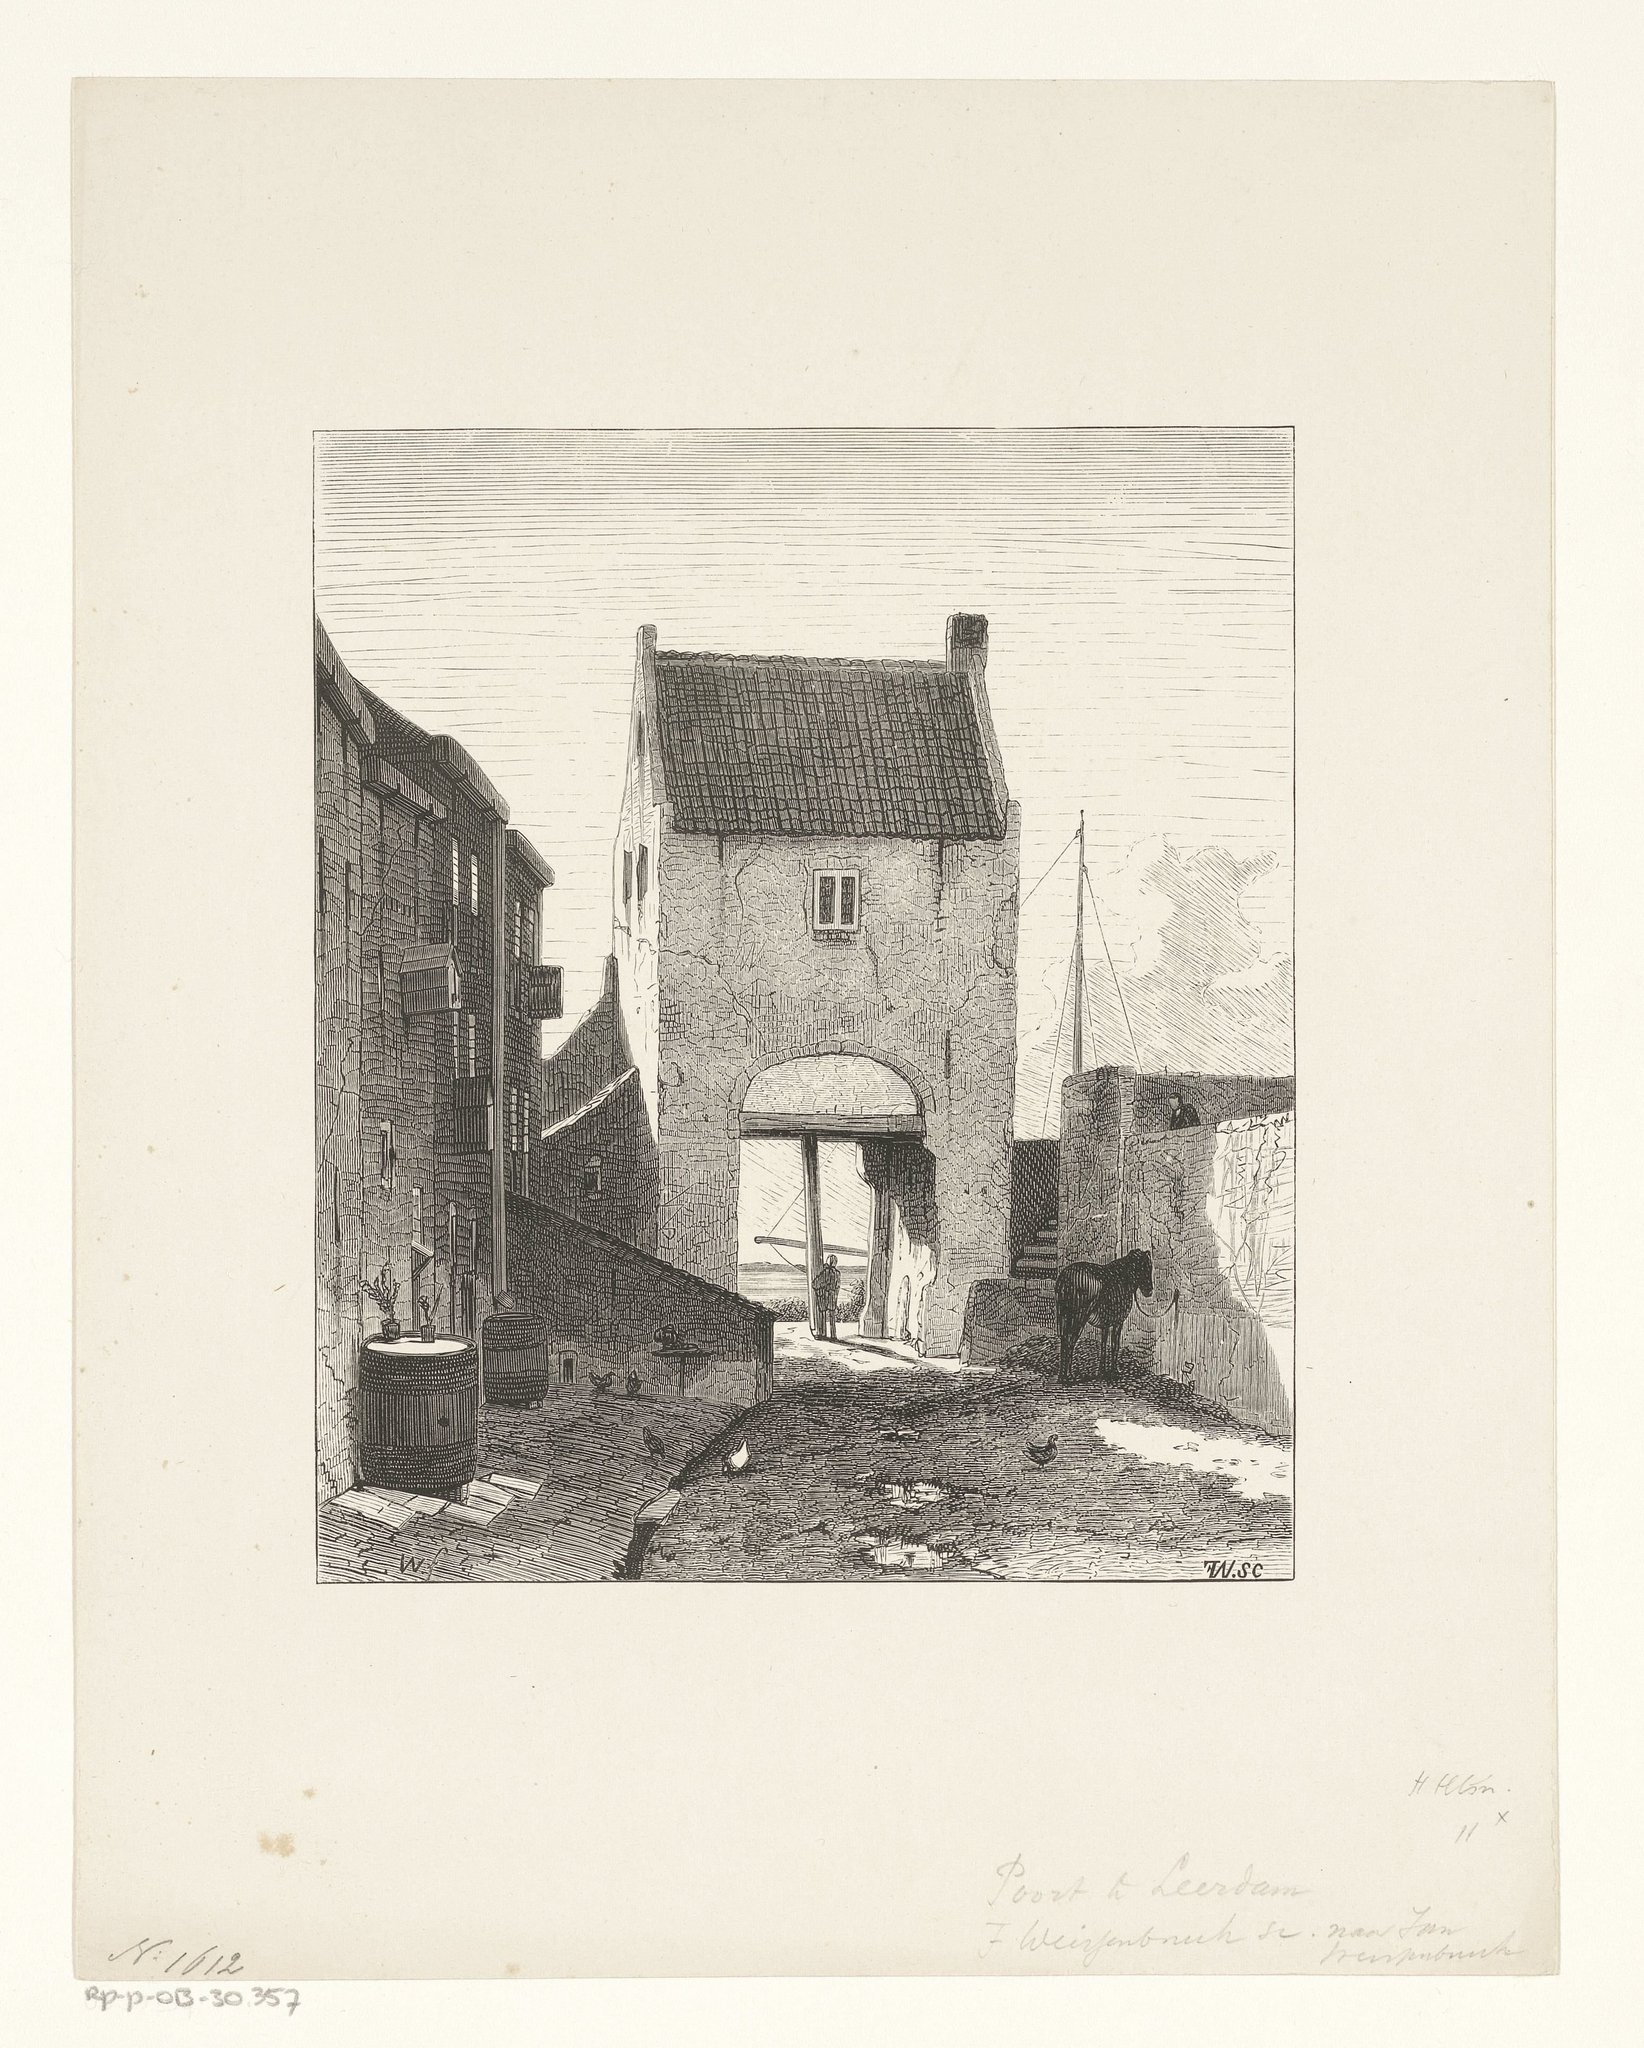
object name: print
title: Gezicht op de Steigerpoort bij de rivier de Linge te Leerdam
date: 1838-1887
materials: paper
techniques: engraving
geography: the hague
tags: horse, city-gate, street (+ city(-scape) with figures, staffage)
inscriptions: collector's mark: Lugt 2228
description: De Steigerpoort te Leerdam. Op straat lopen een man en twee vrouwen, bij een plas scharrelen enkele kippen. Door de poort is de boegspriet van een schip te zien.